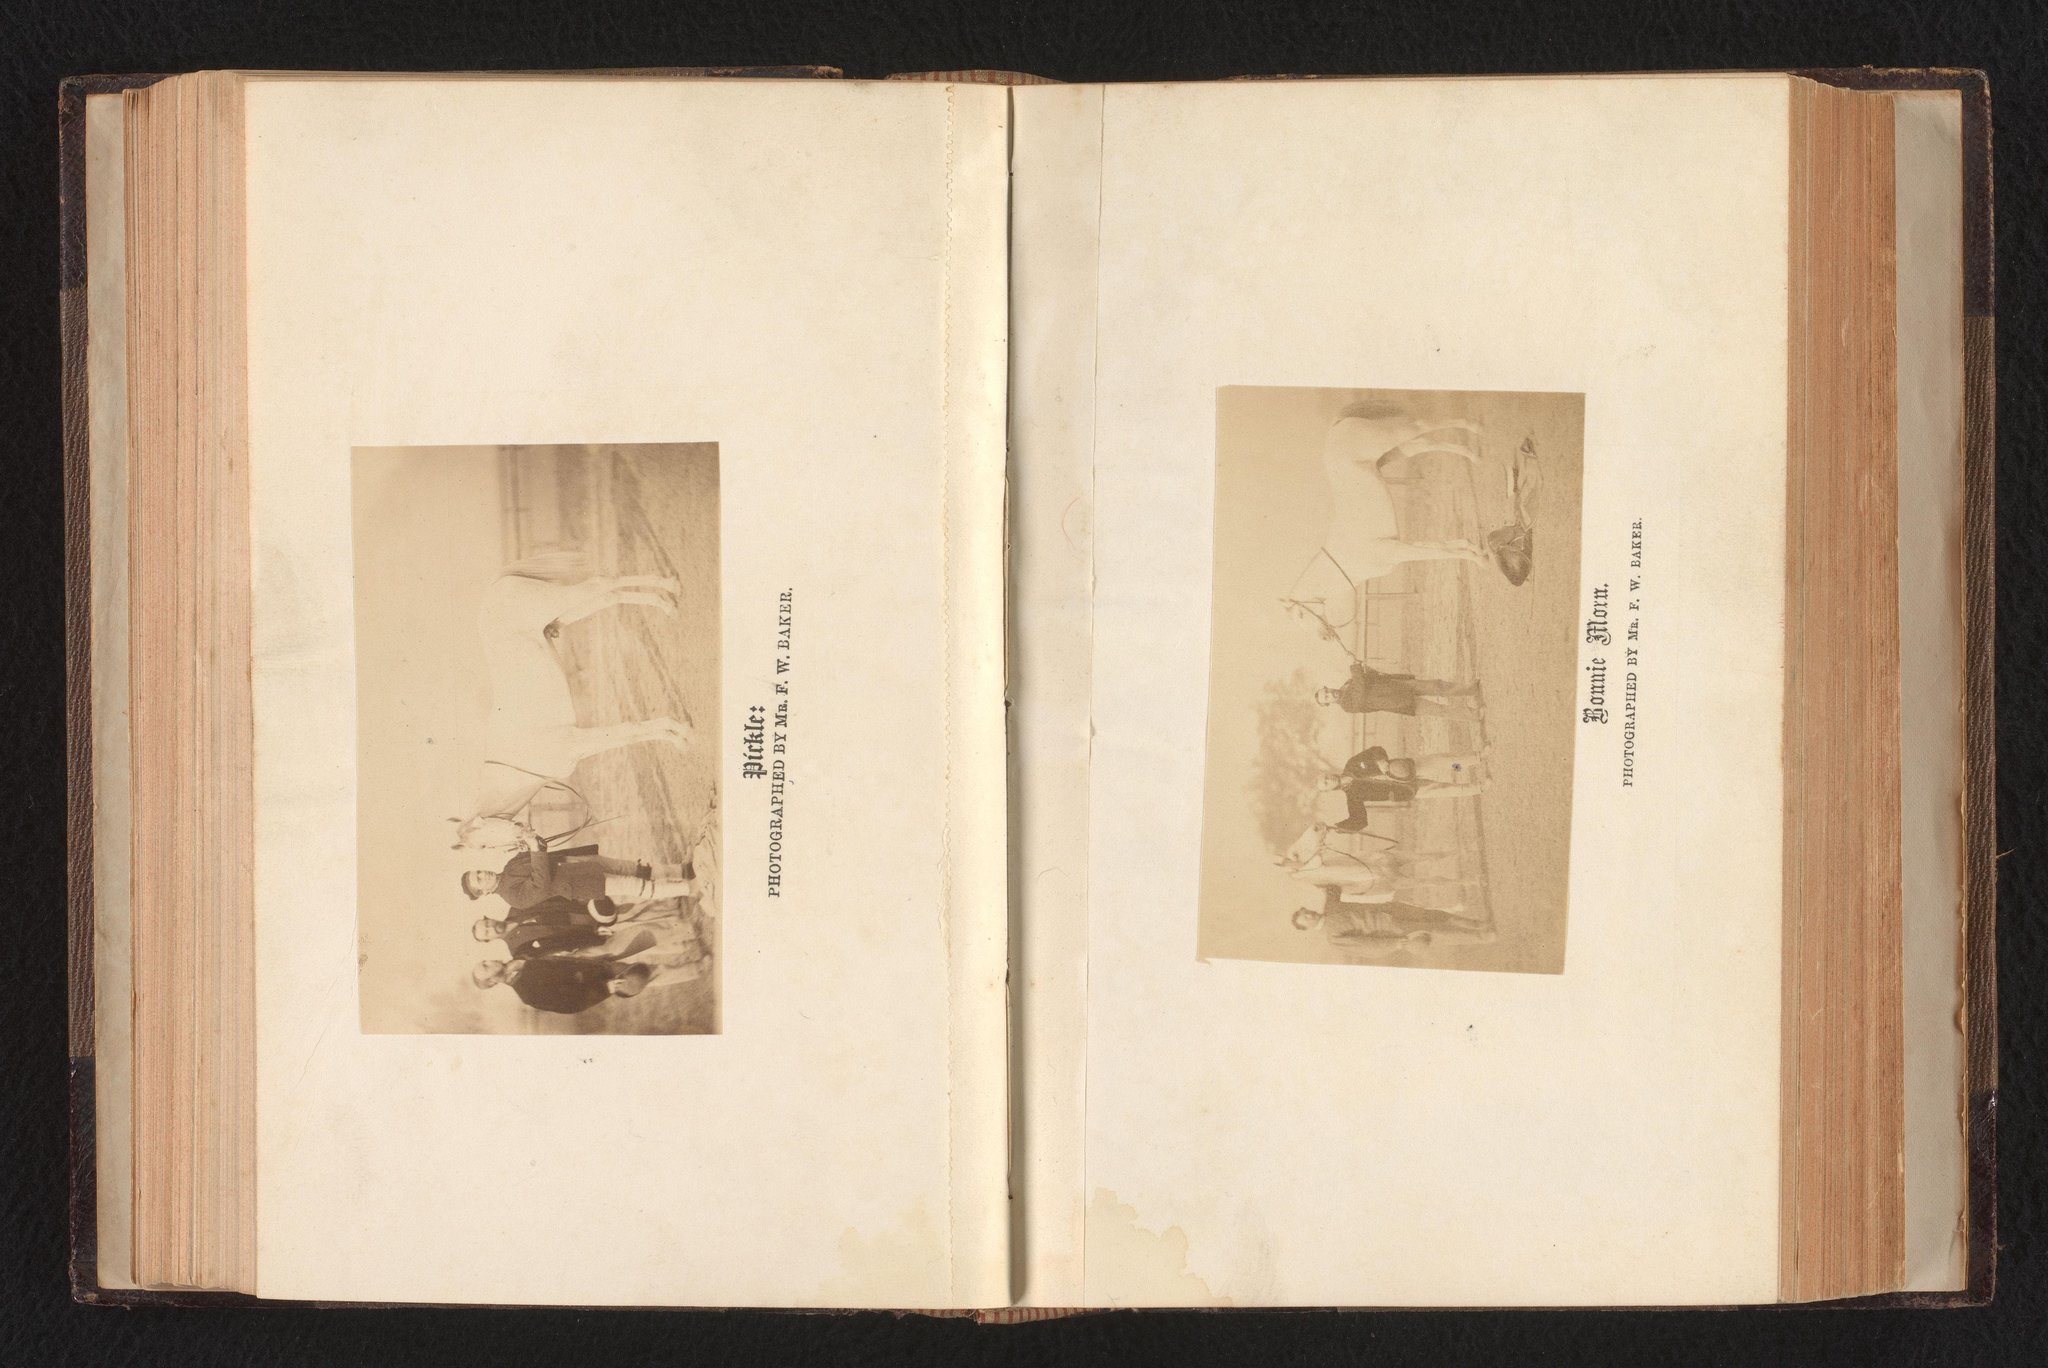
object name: photograph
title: Bonnie Morn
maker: f.w. baker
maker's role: fotograaf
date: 1861-1866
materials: paper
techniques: albumen print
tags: boy (child between toddler and youth), medical examination, medical treatment, historical persons not known by name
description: Foto op vierde ongenummerde pagina na pagina 121.